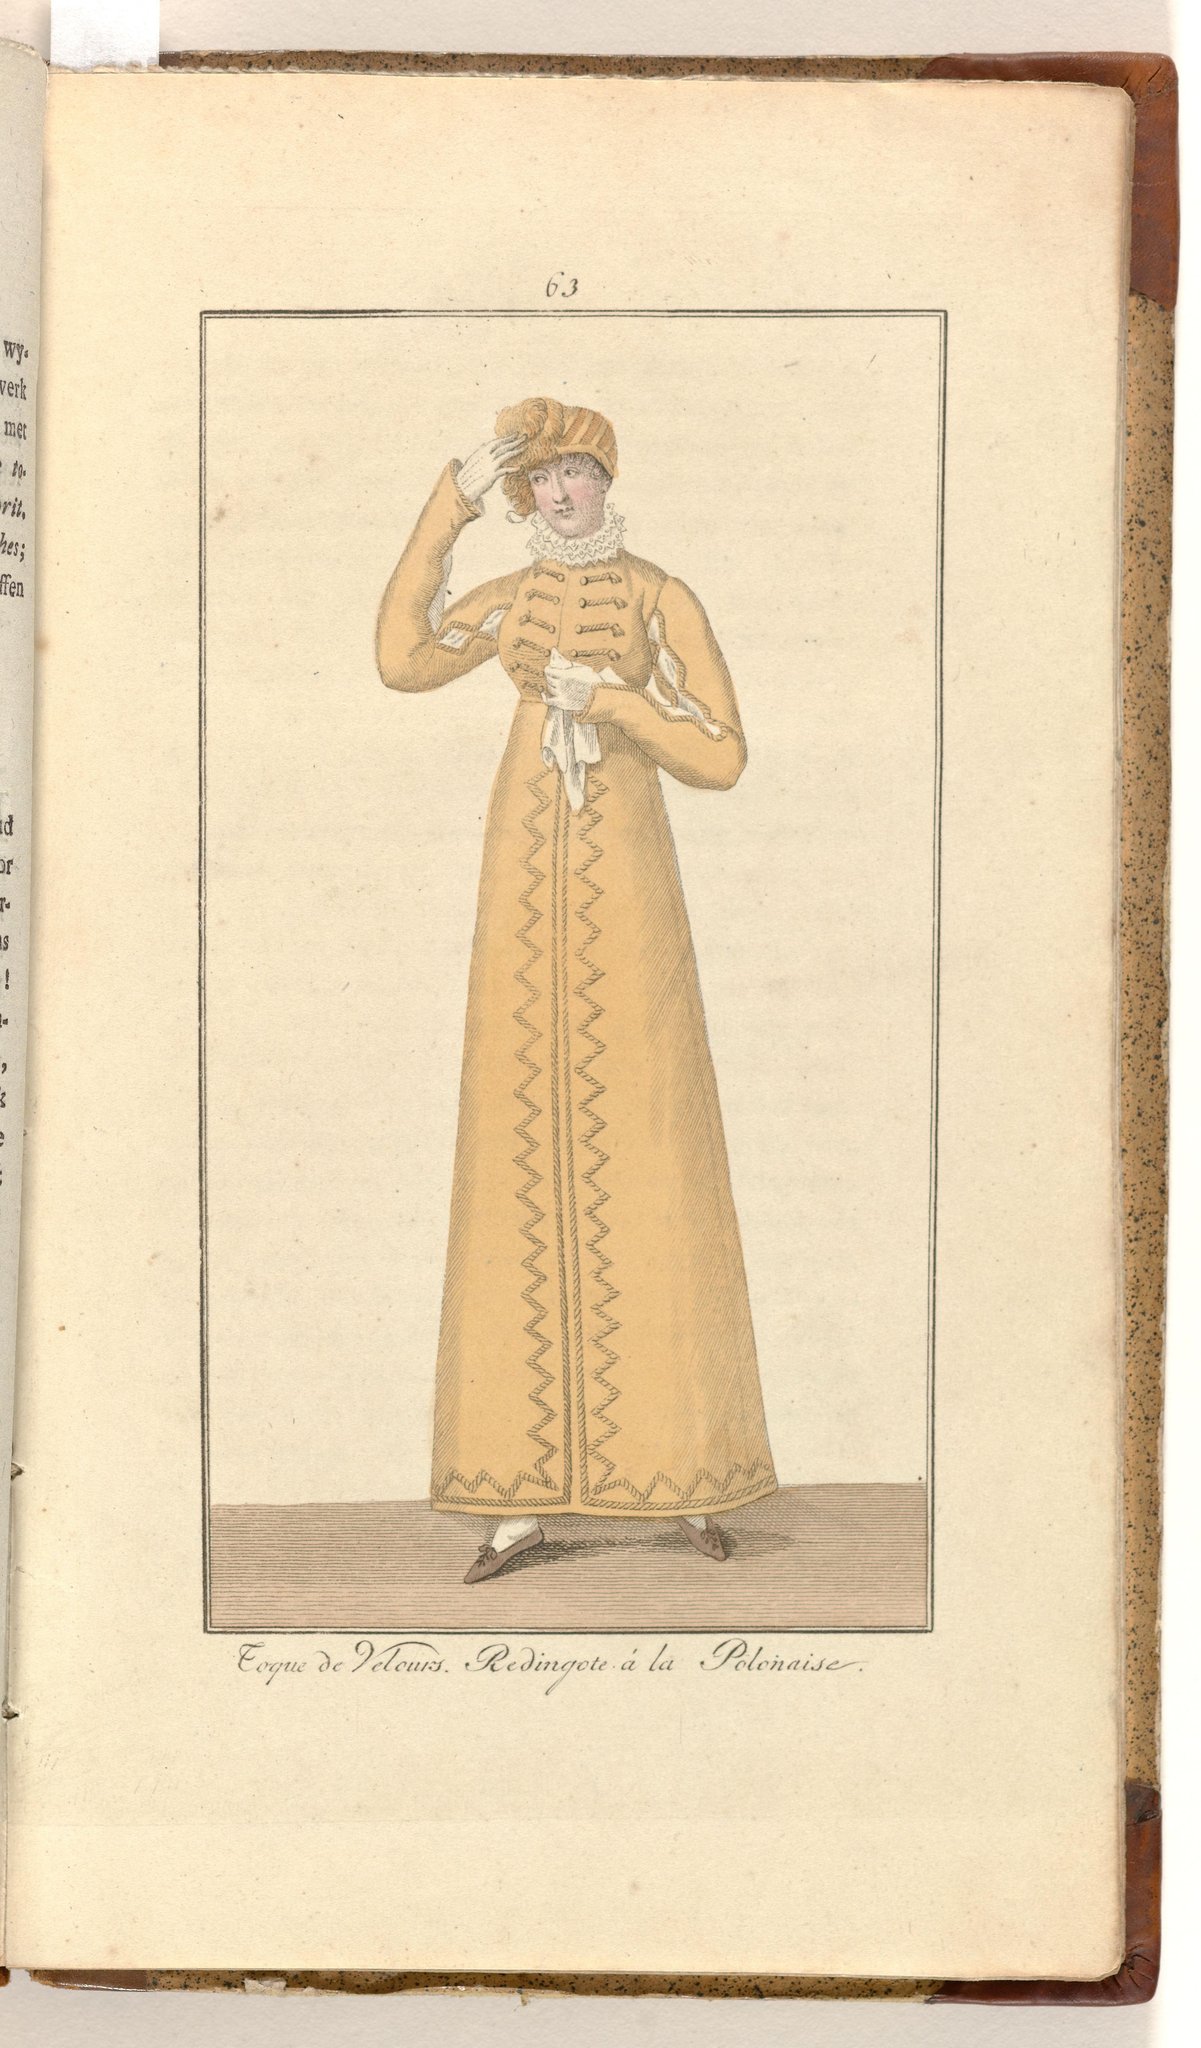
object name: fashion print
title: Elegantia, of tijdschrift van mode, luxe en smaak voor dames, December 1808, No. 63: Toque de velours...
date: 1808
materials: paper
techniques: engraving, hand coloring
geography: amsterdam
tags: handkerchief (+ women's clothes), head-gear: toque (+ women's clothes), border, ribbon, braid (+ women's clothes), dress, gown: redingote (+ women's clothes), fashion plates, shoes, sandals (+ women's clothes)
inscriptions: caption: ‘Toque de Velours. Redingote á la Polonaise.’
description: Volgens de begeleidende tekst (p. 384): Redingote met belegsels van koord 'en zigzag' en lussen à la polonaise'. Toque van rozerood fluweel, gecoupeerd met wit satijn. Prent uit het modetijdschrift Elegantia, of tijdschrift van mode, luxe en smaak voor dames 1807-1814 (onderbroken door de periode 1811-1813).